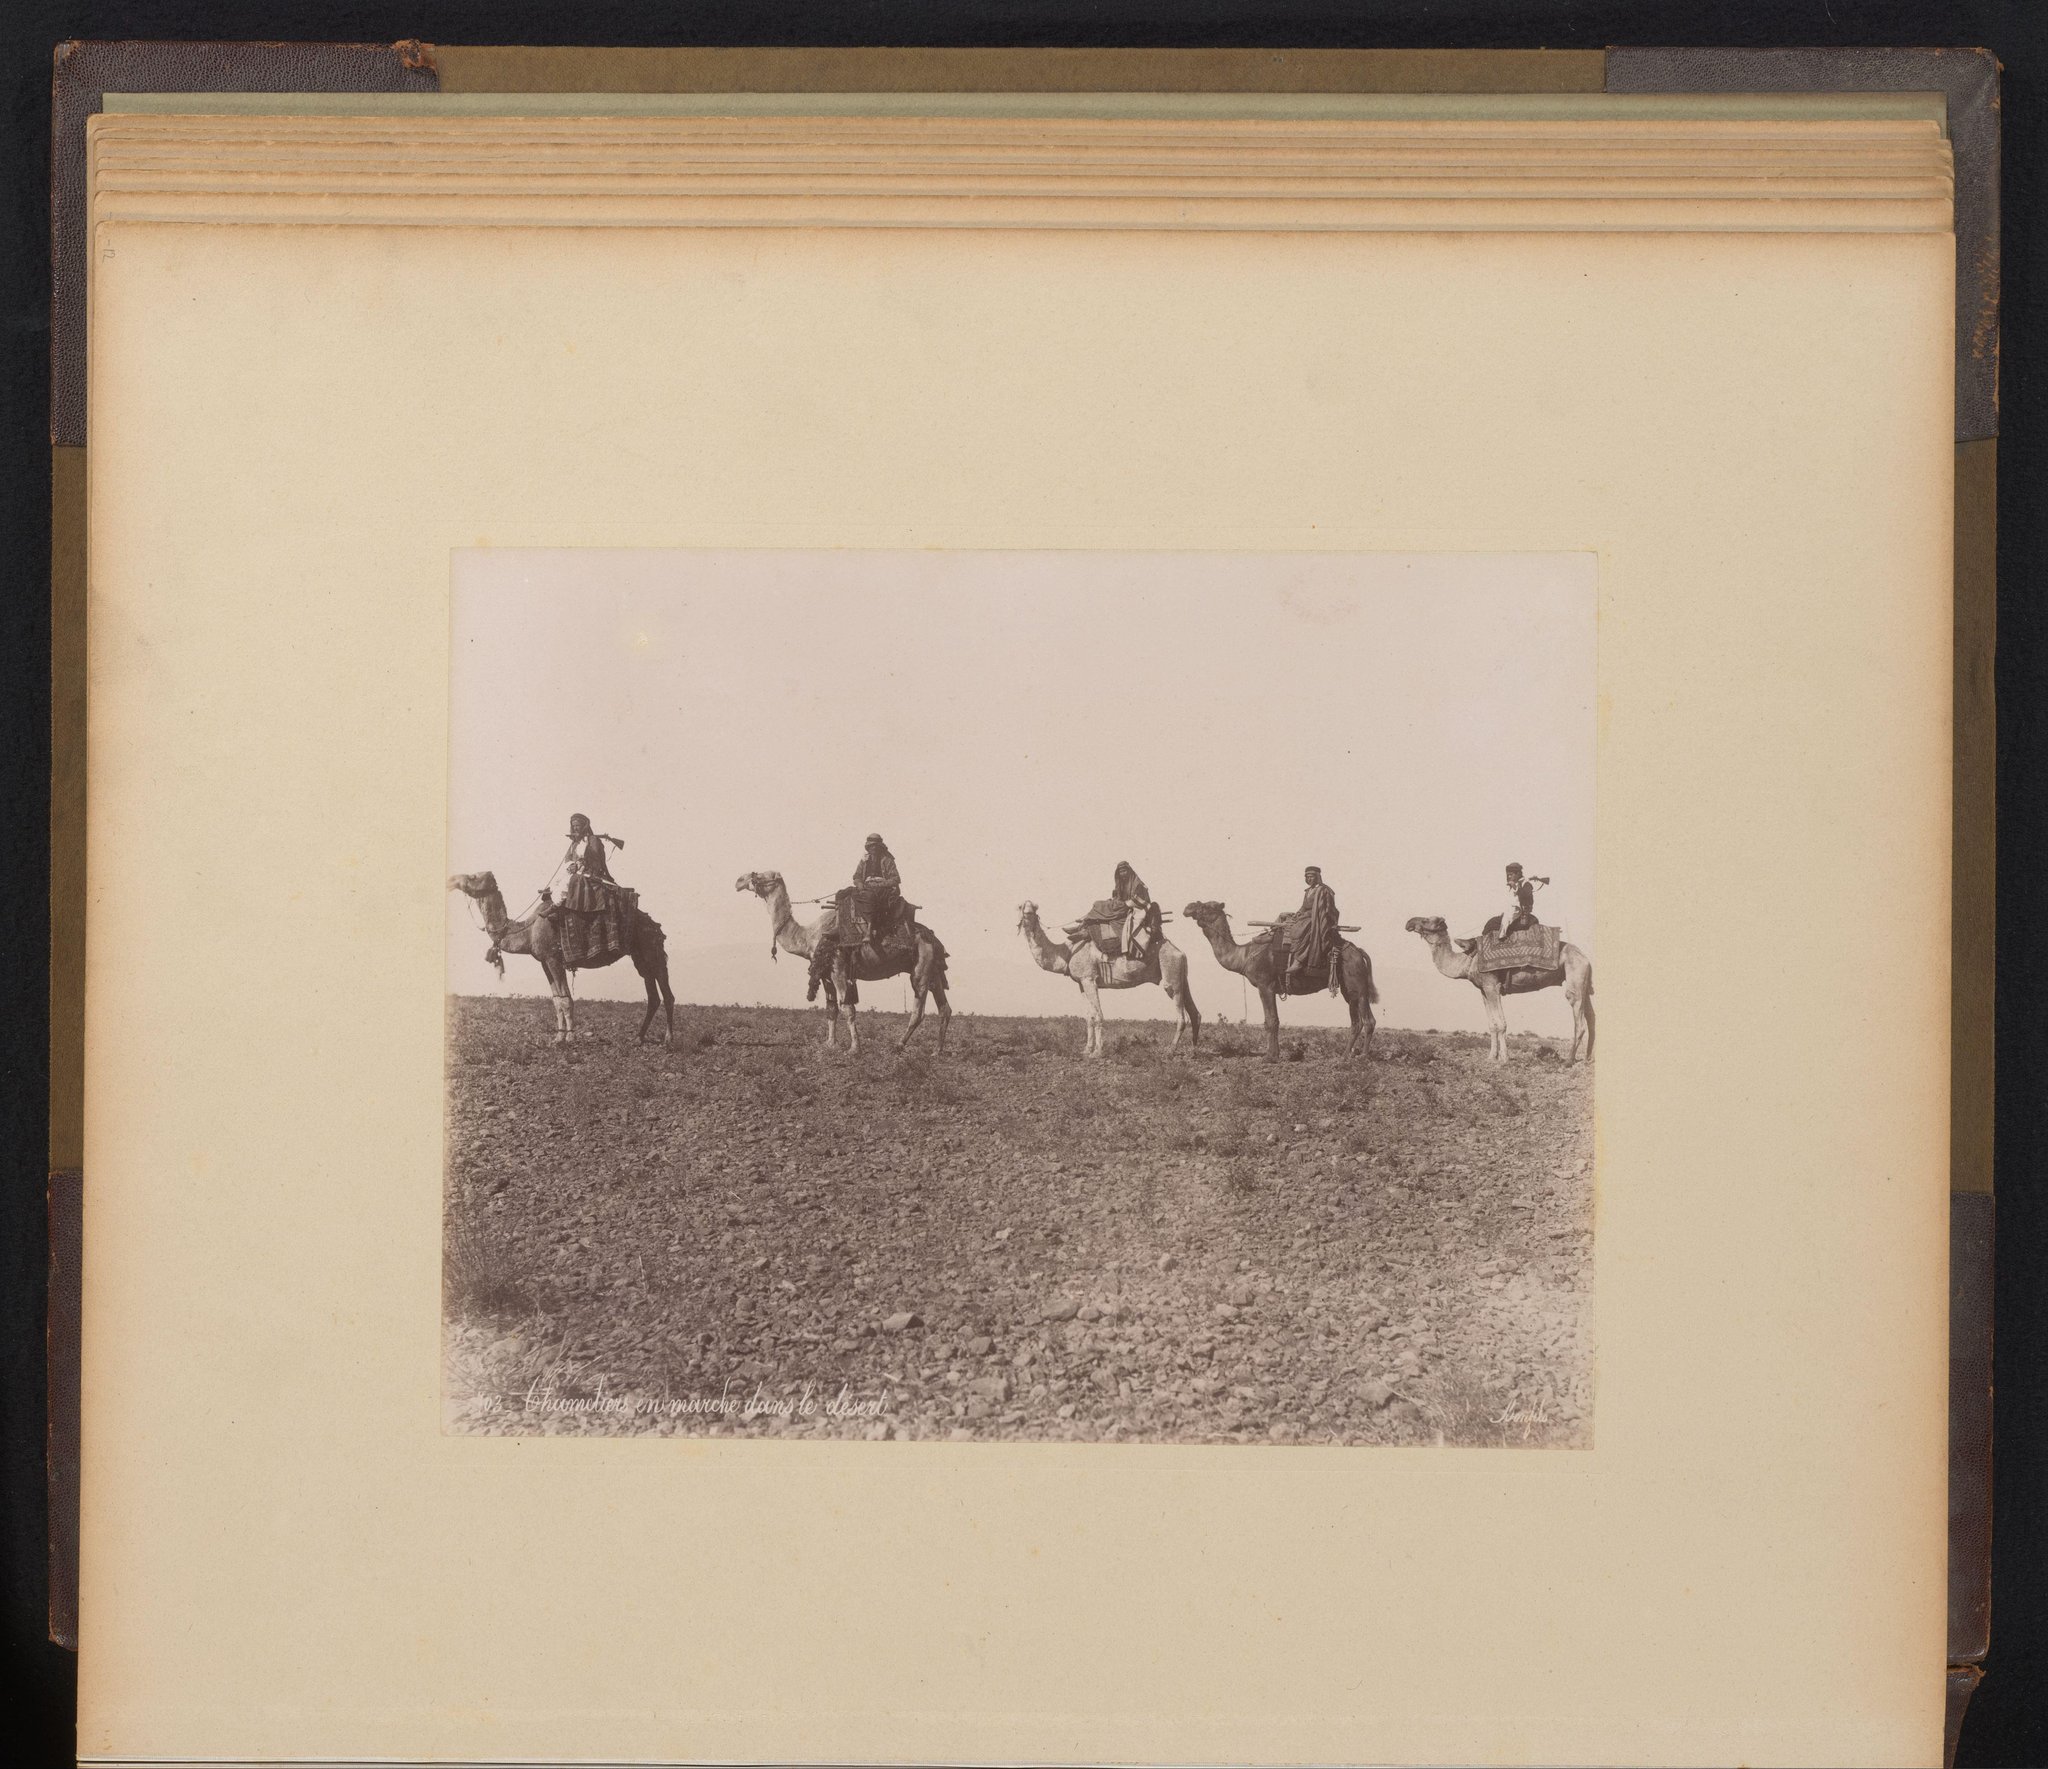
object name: photograph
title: Chameliers en marche dans le désert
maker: félix bonfils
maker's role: fotograaf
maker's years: 1831-1885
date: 1867-1885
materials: paper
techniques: albumen print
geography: middle east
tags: hoofed animals: dromedary, desert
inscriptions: number: ‘703’